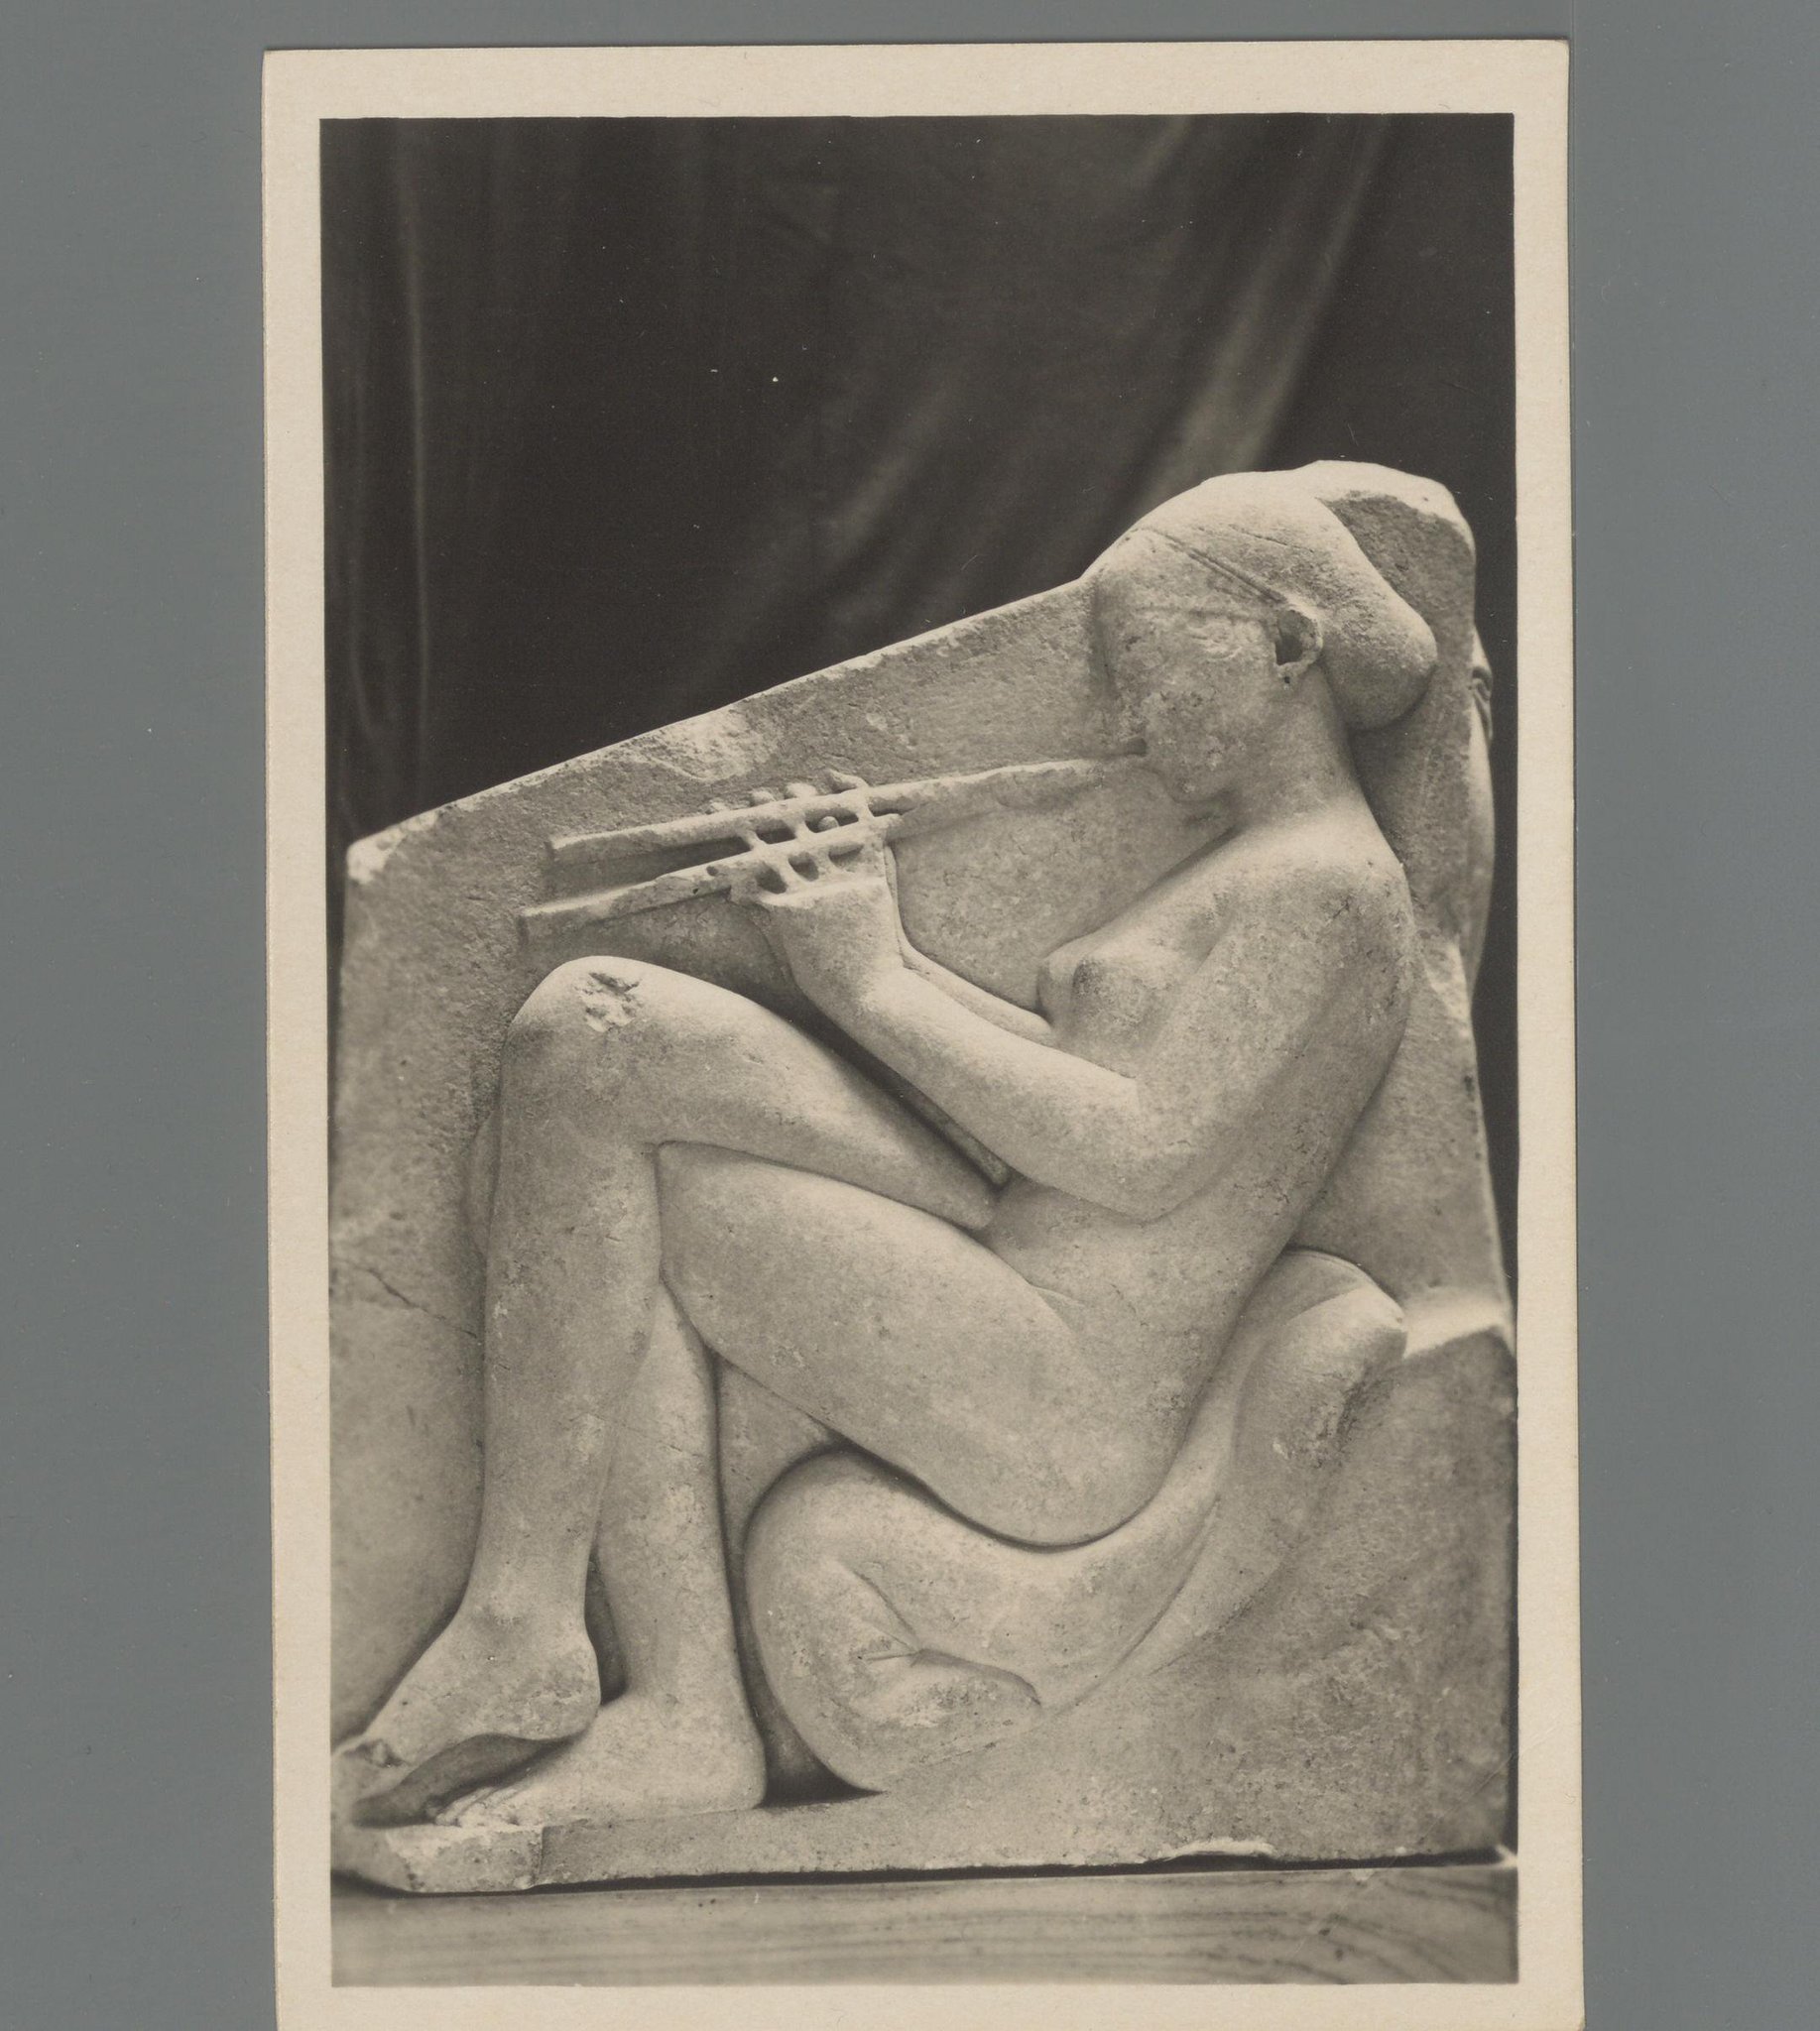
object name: ansichtkaart, prentbriefkaart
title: Roma - Museo Nazionale - Fianco del Trono Ludovisi. Una flautista (arte del V secolo)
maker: Anonymous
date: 1906-1930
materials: paper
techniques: gelatin silver print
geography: rome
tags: statues, paintings, etc. ~ objects of worship in roman religion, permanent exhibition, museum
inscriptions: collector's mark: ‘AFE v S’